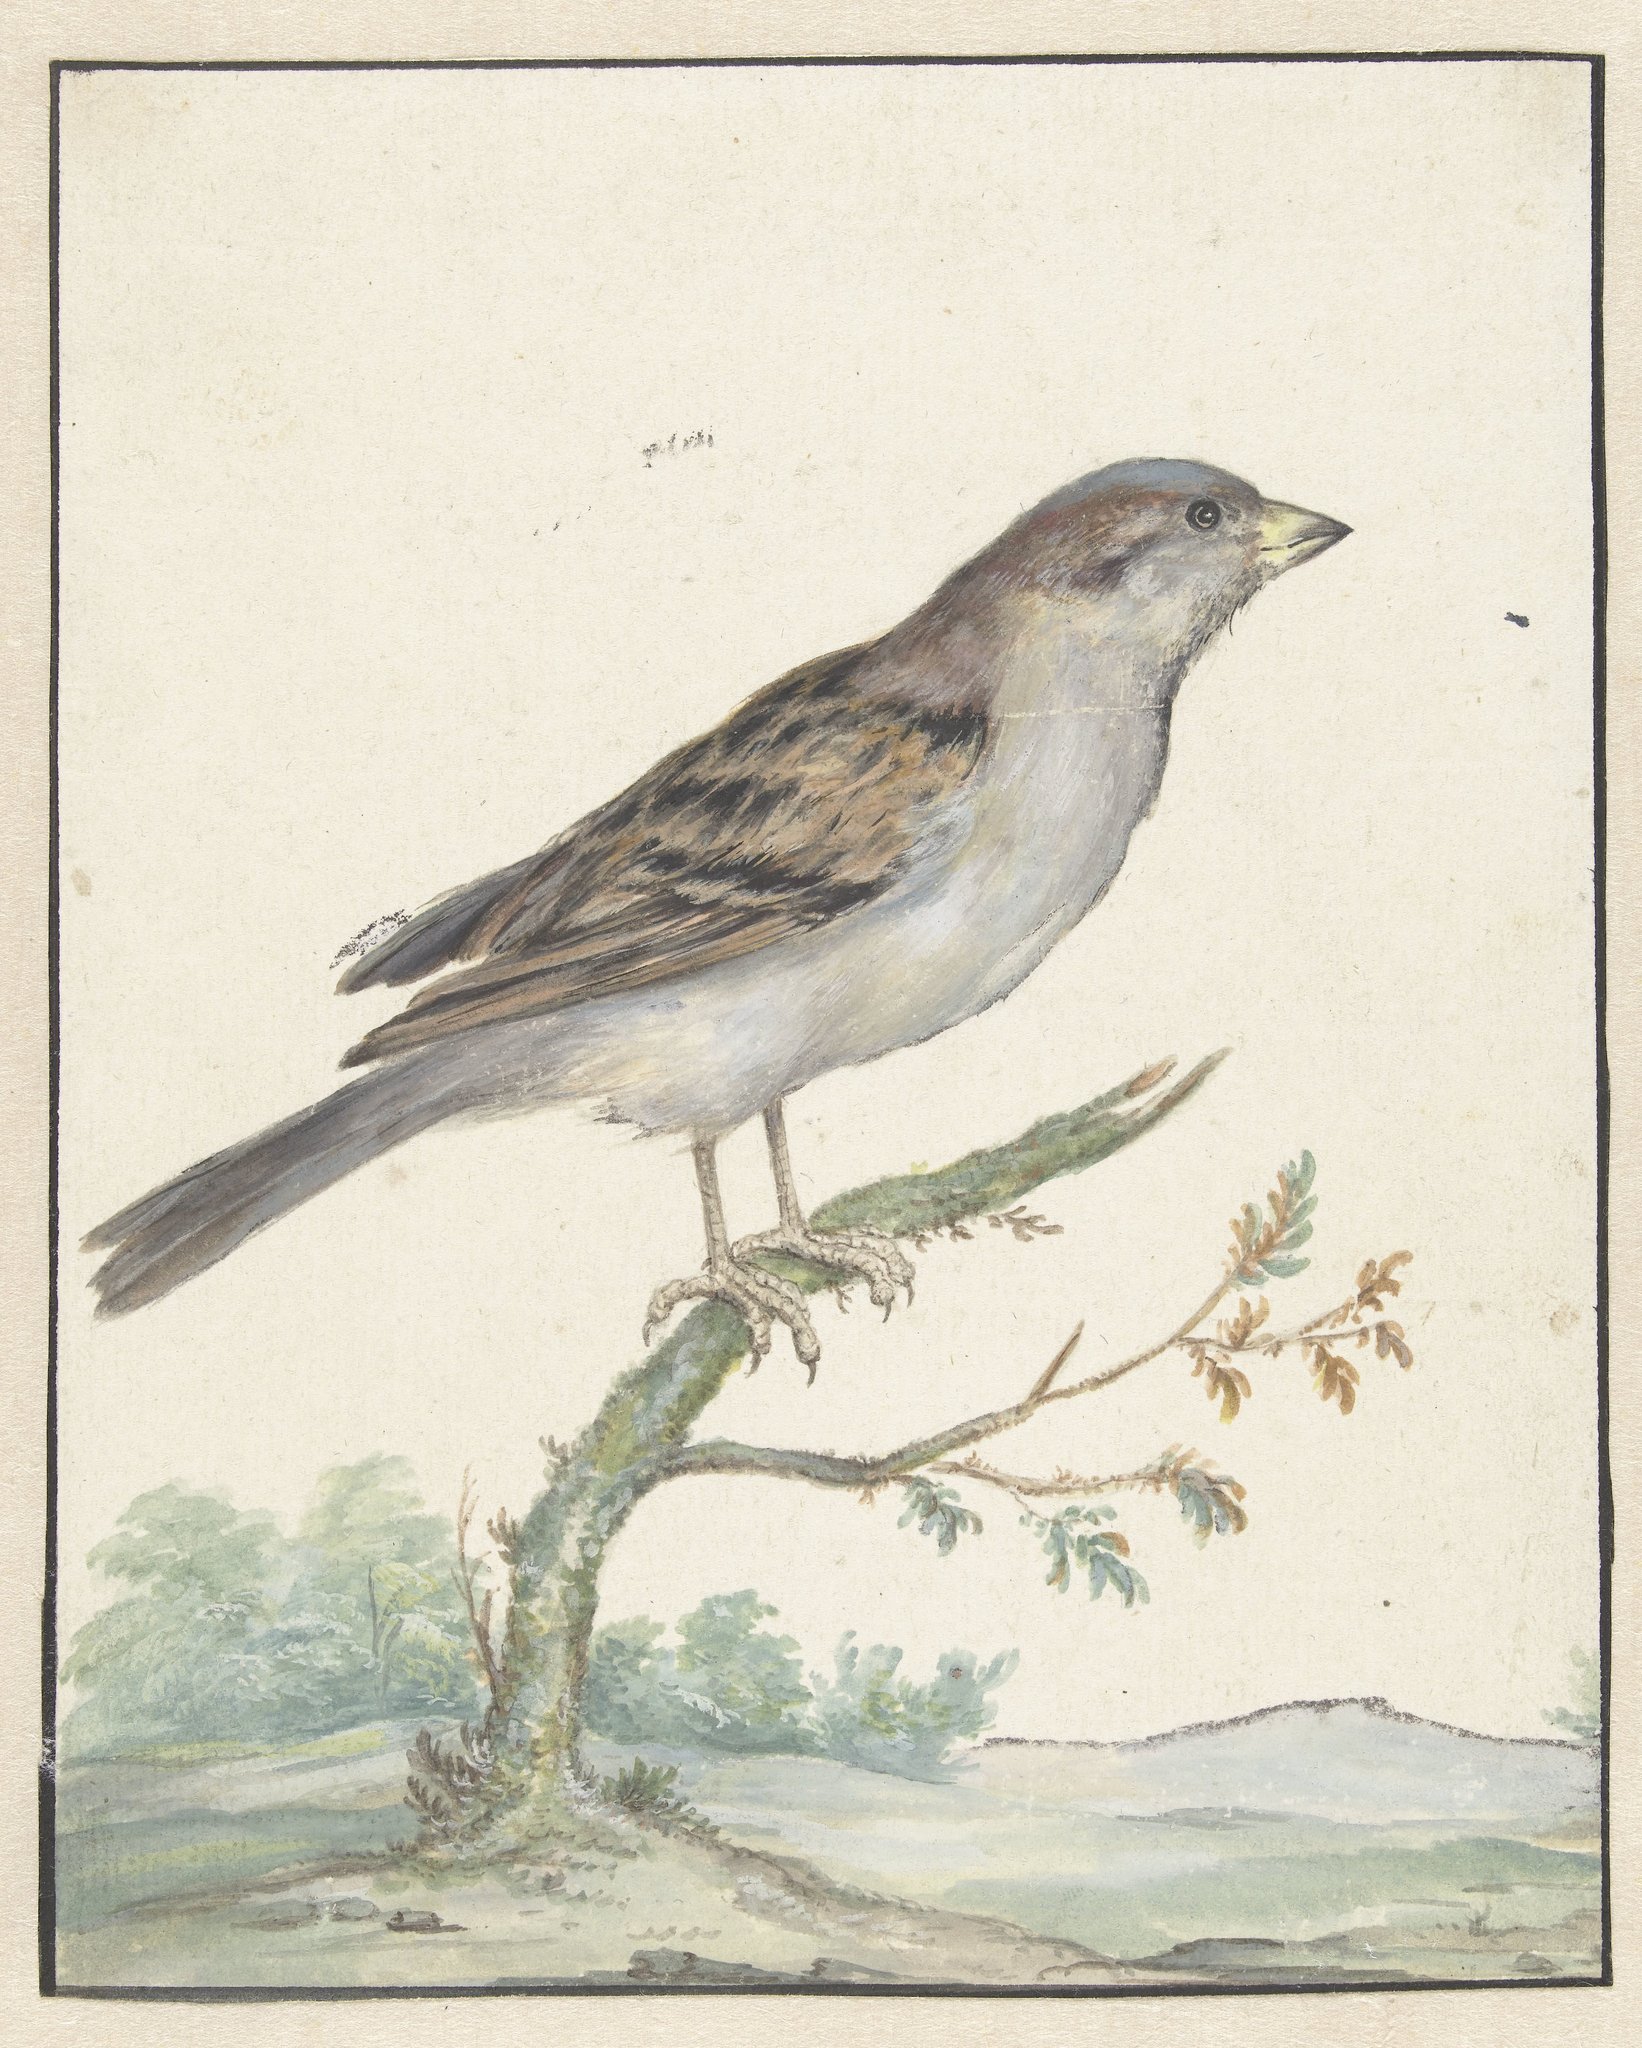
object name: drawing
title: Huismus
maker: jan weenix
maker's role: draughtsman, painter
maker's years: 1640-1719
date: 1650-1719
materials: paper, watercolor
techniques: brush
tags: song-birds: sparrow